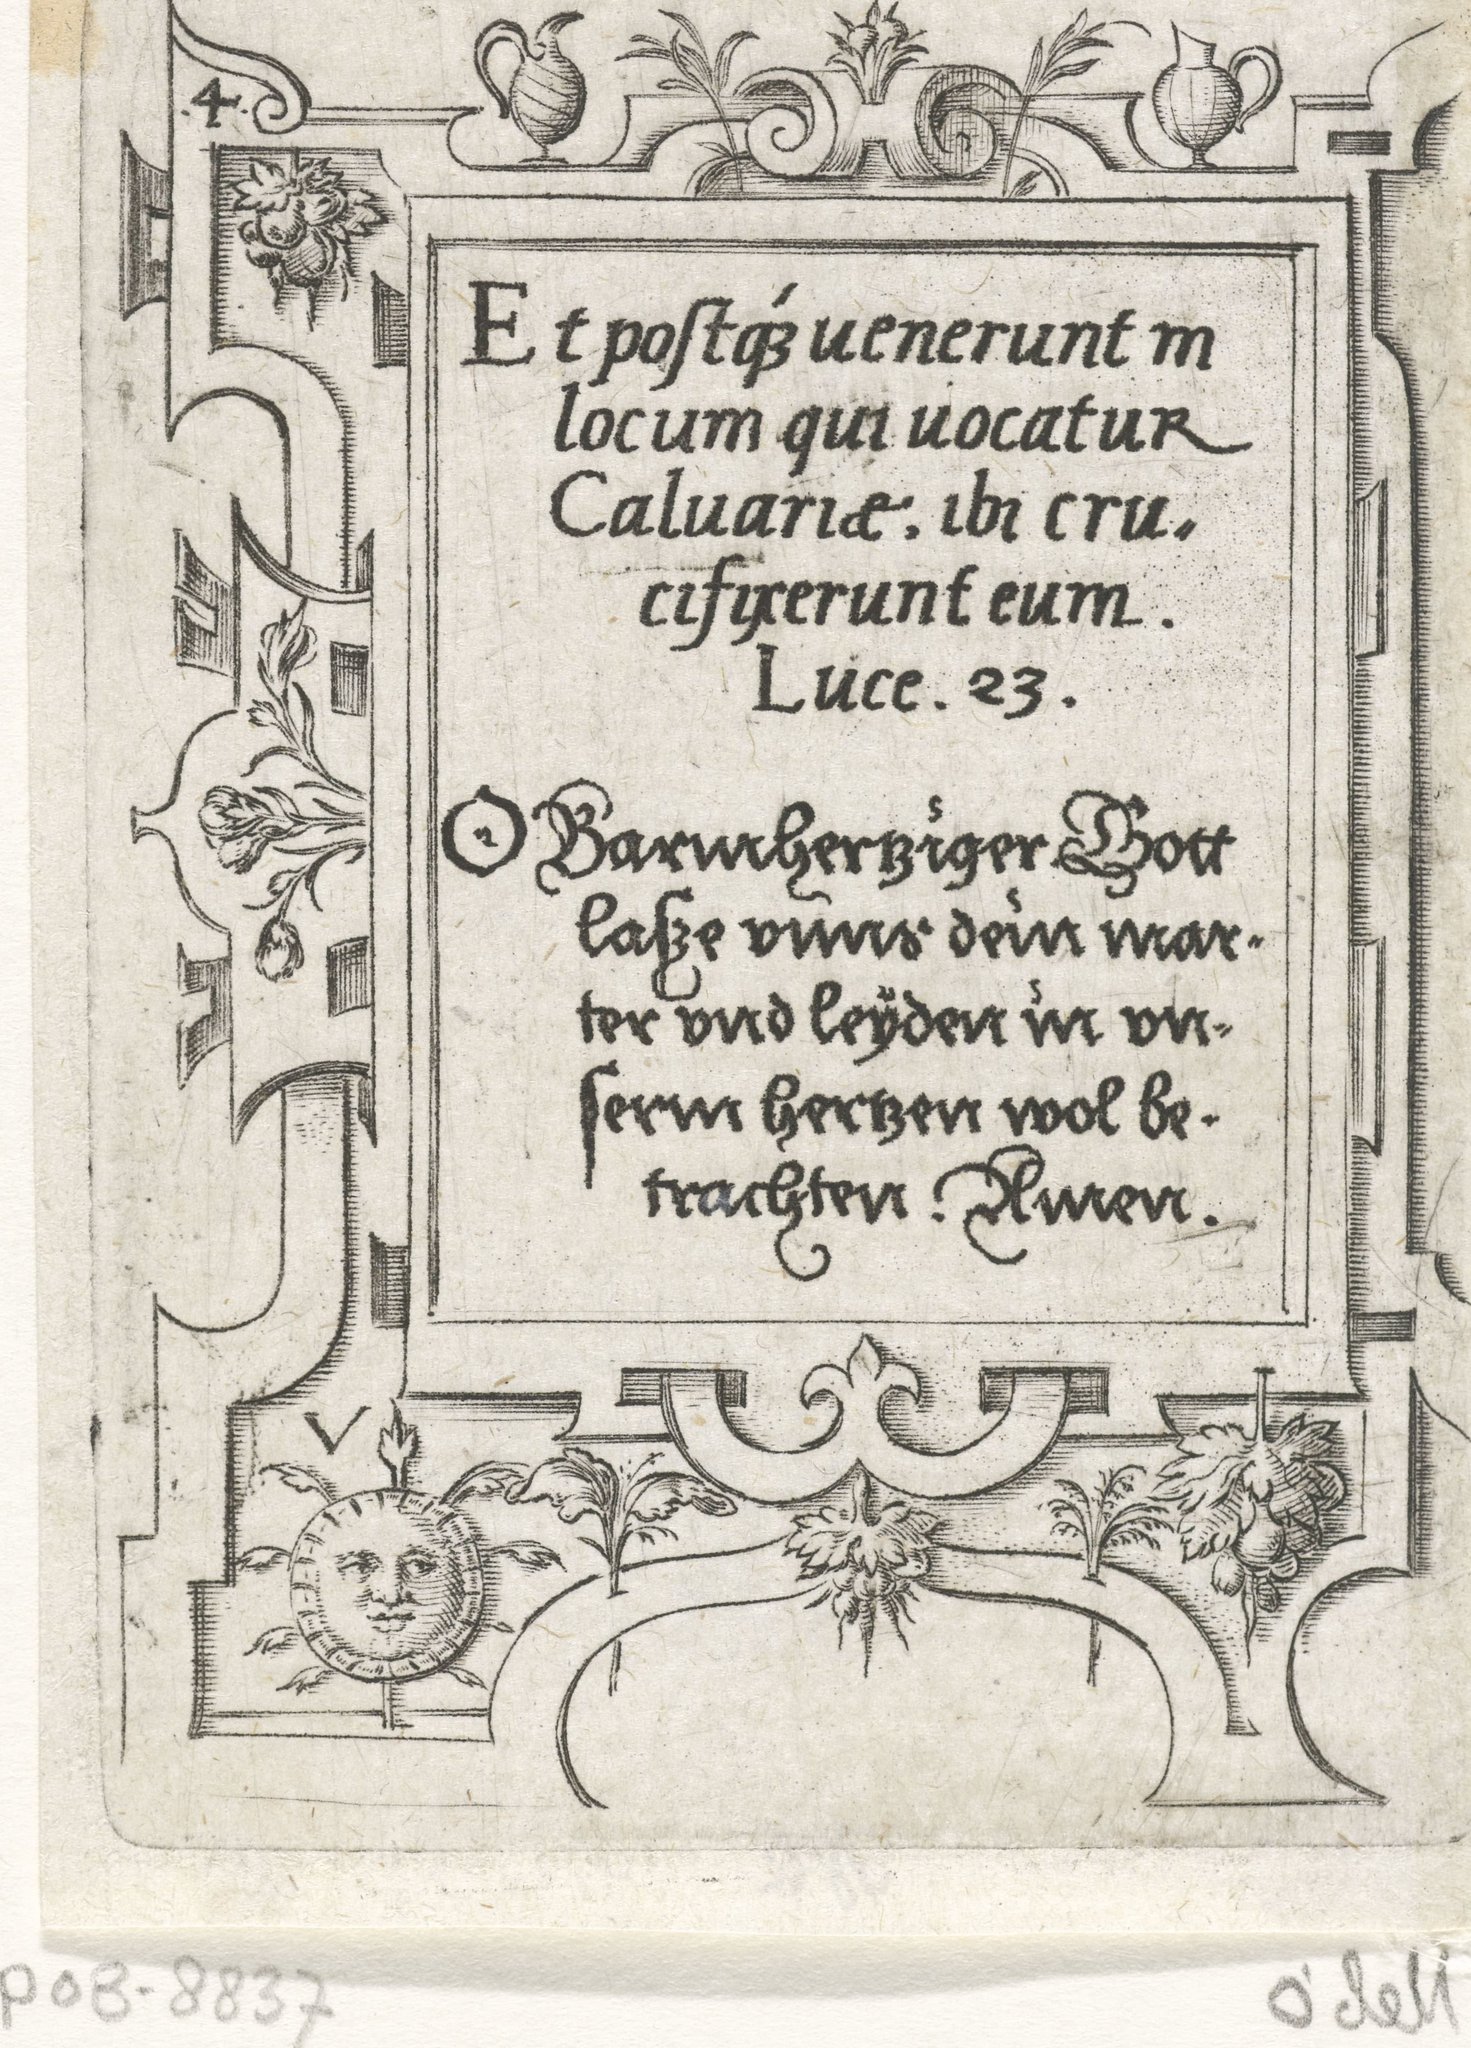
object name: print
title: Tekst: Et post...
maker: virgilius solis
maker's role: draughtsman, print maker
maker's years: 1514-1562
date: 1524-1562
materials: paper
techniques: engraving